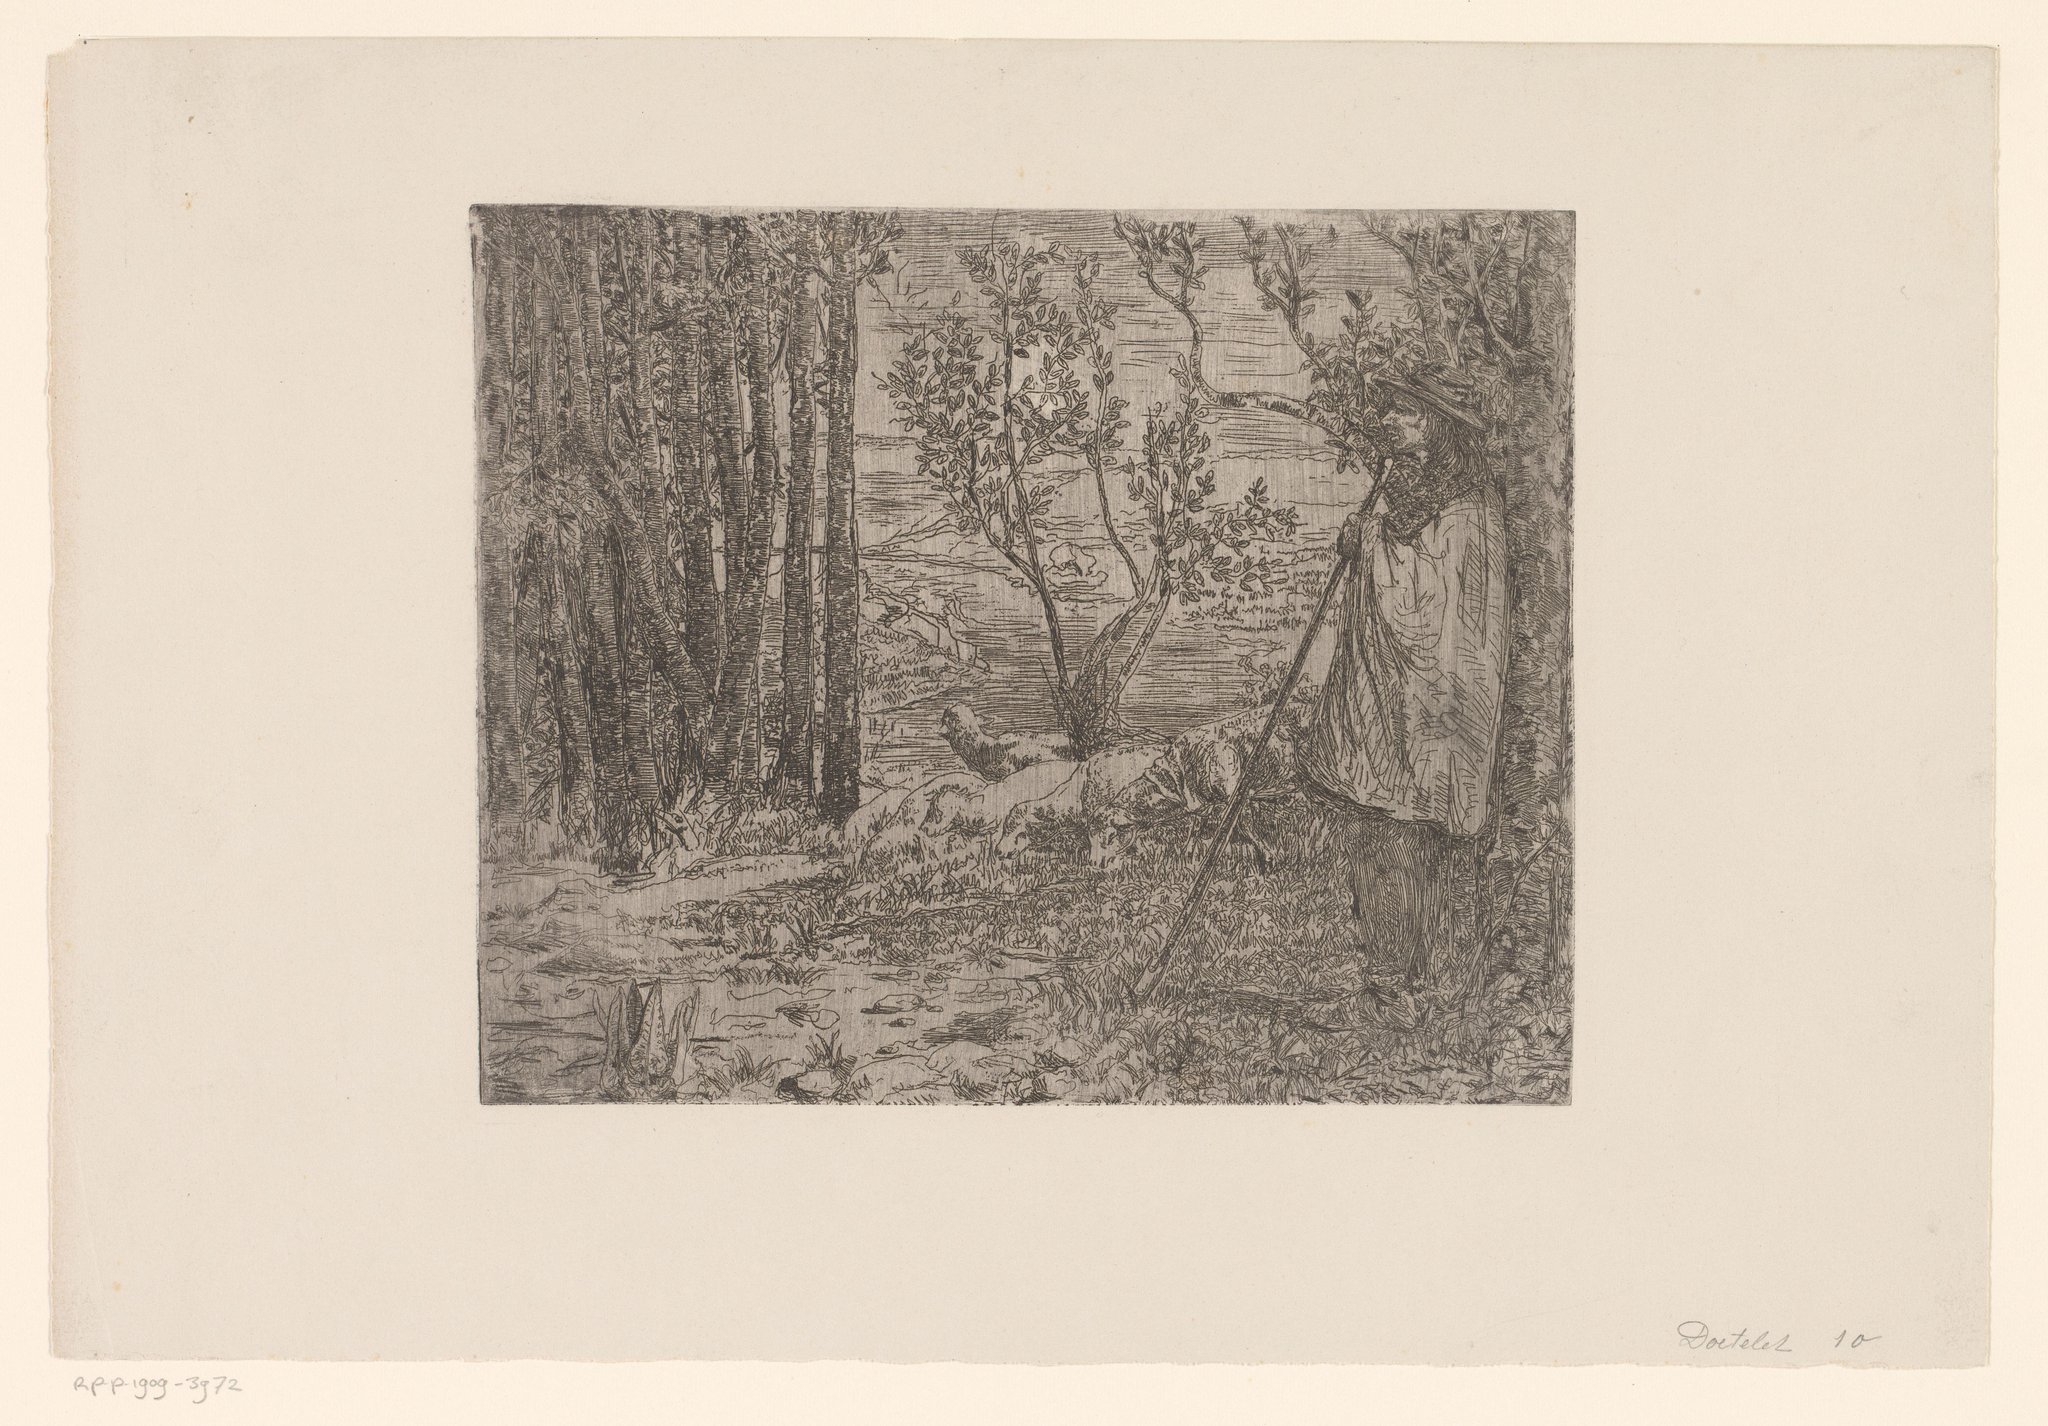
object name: print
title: Herder met schapen in een bos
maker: charles doudelet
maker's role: print maker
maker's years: 1861-1938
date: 1871-1909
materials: paper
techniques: etching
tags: herding, herdsman, herdswoman, shepherd, shepherdess, cowherd, etc., forest, wood, sheep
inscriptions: collector's mark: Lugt 2228